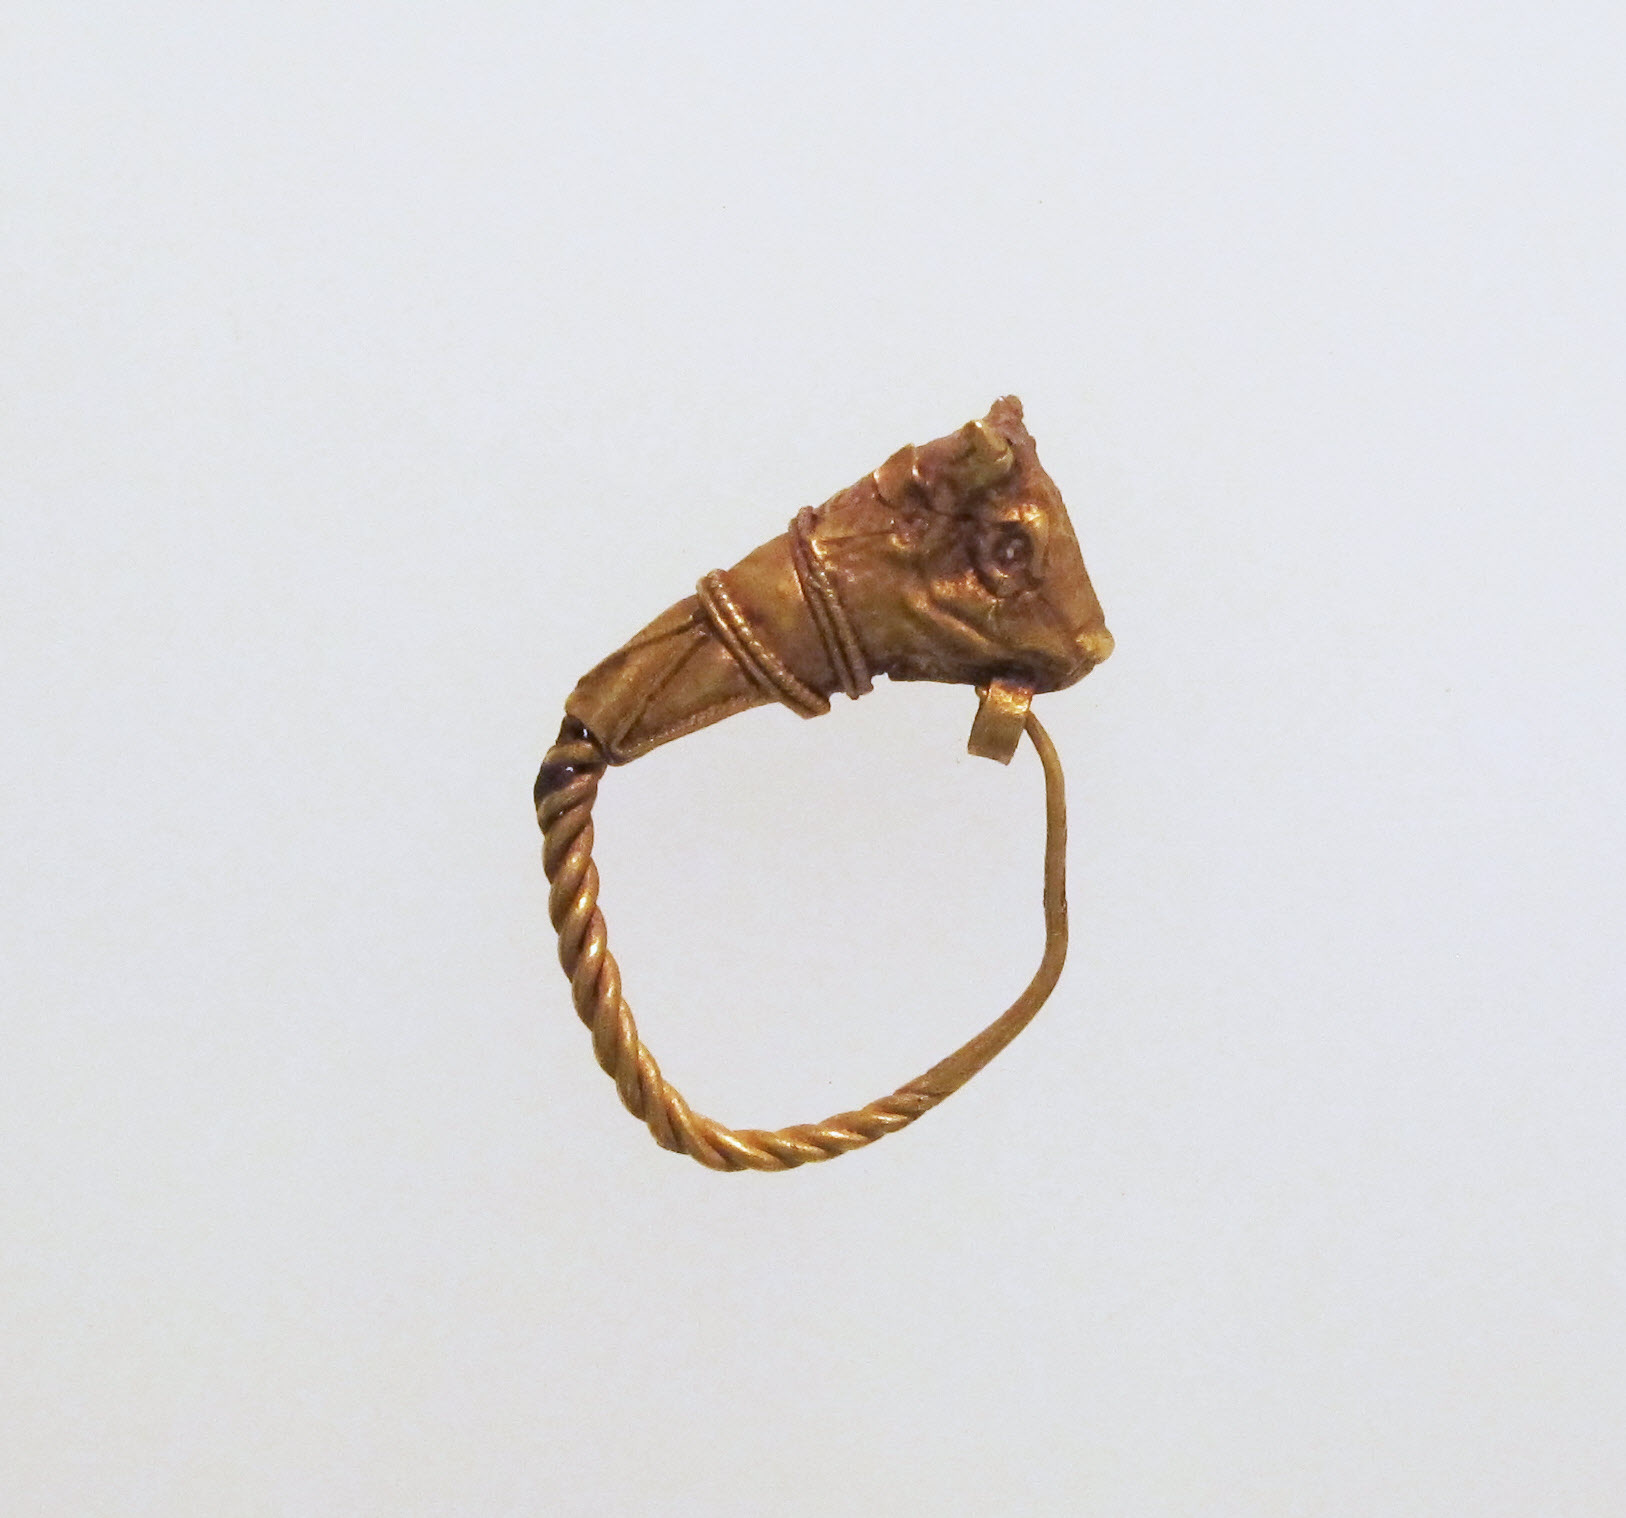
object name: earring with head of bull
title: Gold earring with head of a bull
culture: greek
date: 400-201 BCE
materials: gold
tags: bulls